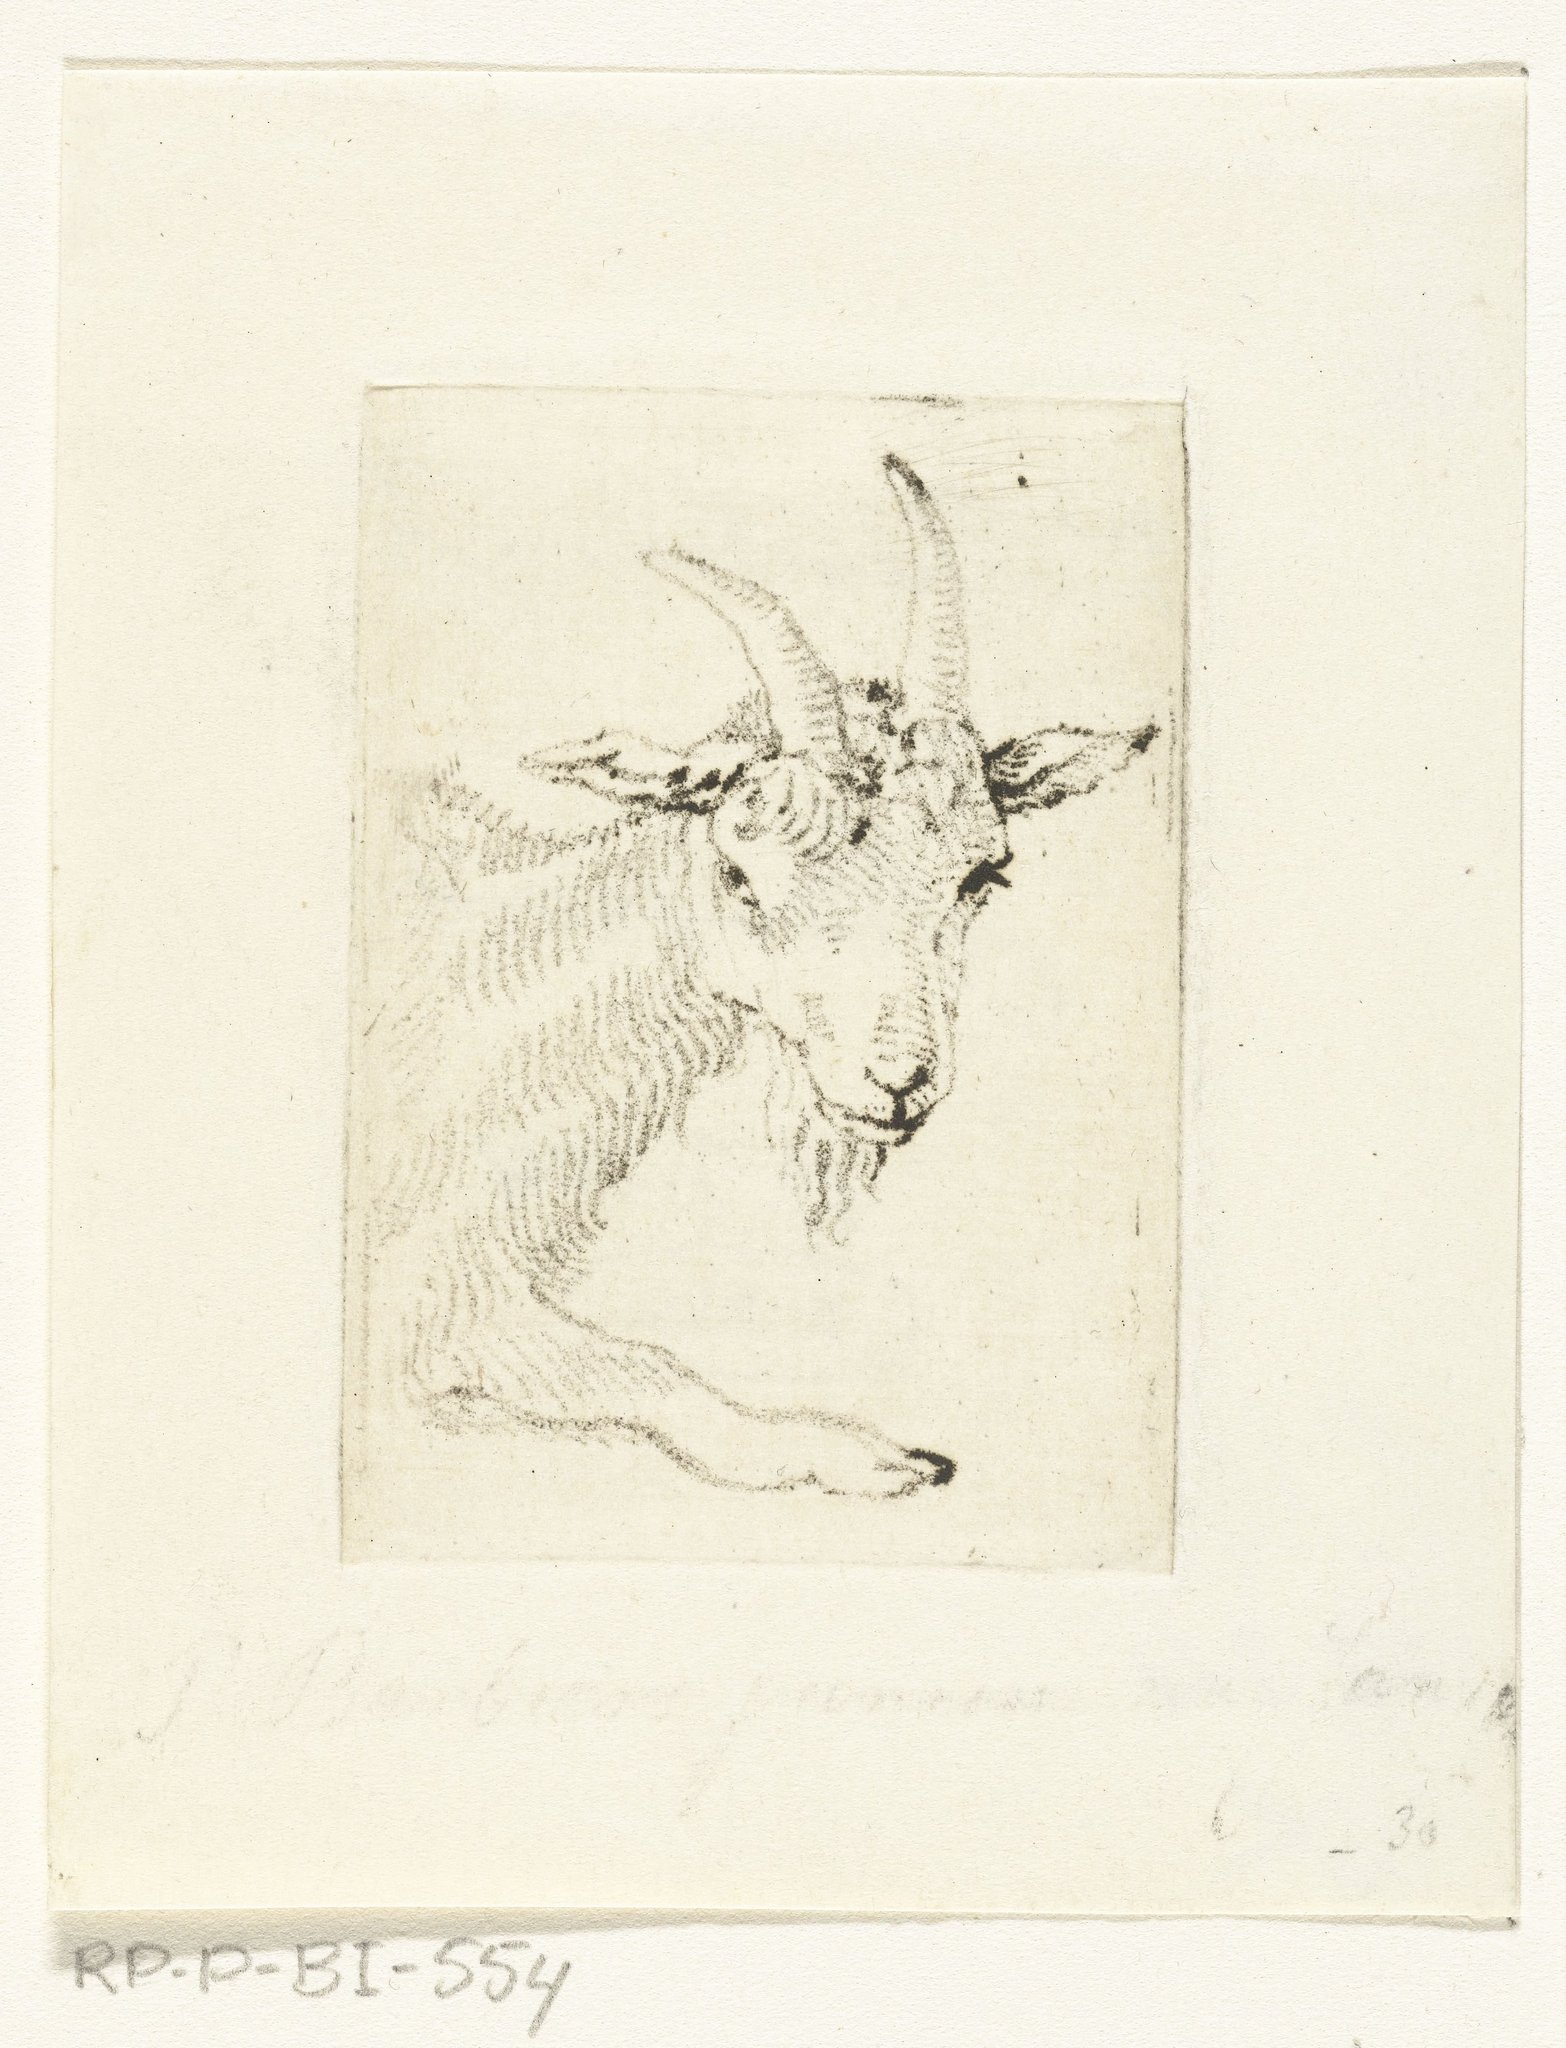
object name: print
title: Kop en voorpoot van liggende bok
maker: pieter barbiers (iv)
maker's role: painter, print maker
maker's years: 1798-1848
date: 1808-1848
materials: paper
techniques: soft ground etching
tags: he-goat, billy-goat, animals (+ postures of the head ~ animal)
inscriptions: collector's mark: Lugt 2228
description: Volgens opschrift op verso naar Jansson.